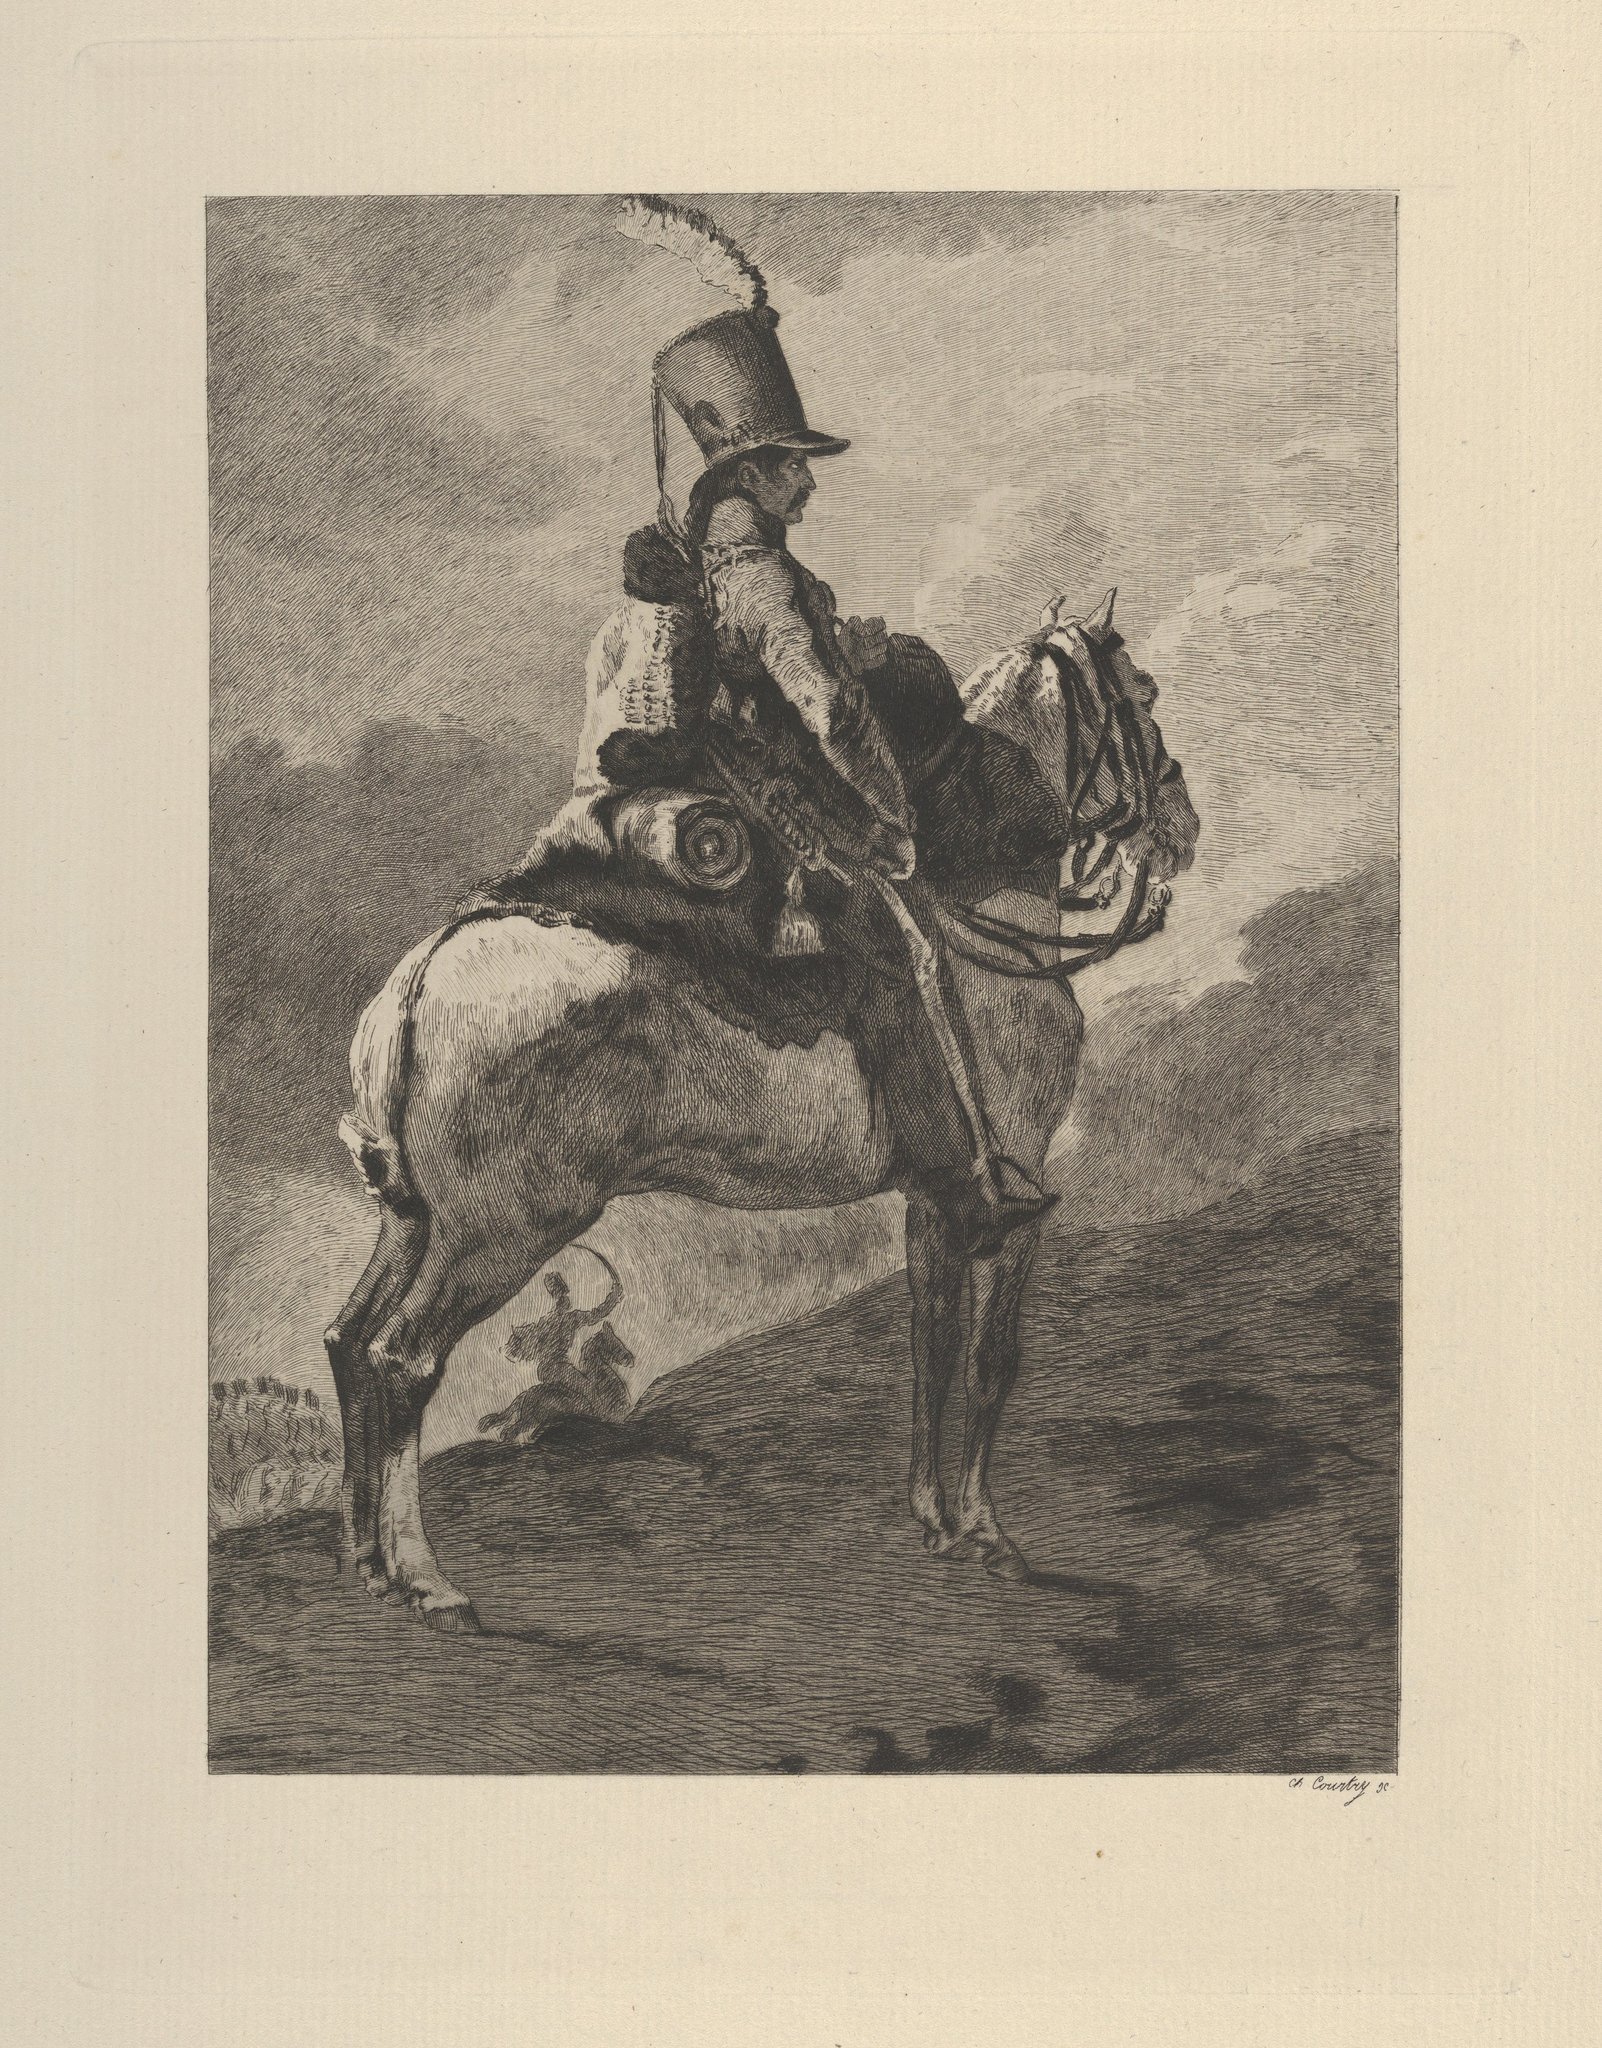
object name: print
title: Trumpeter of the Hussars on Horseback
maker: charles courtry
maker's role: etcher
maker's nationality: french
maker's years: 1846-1897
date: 1866-1897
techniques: etching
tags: men,horses